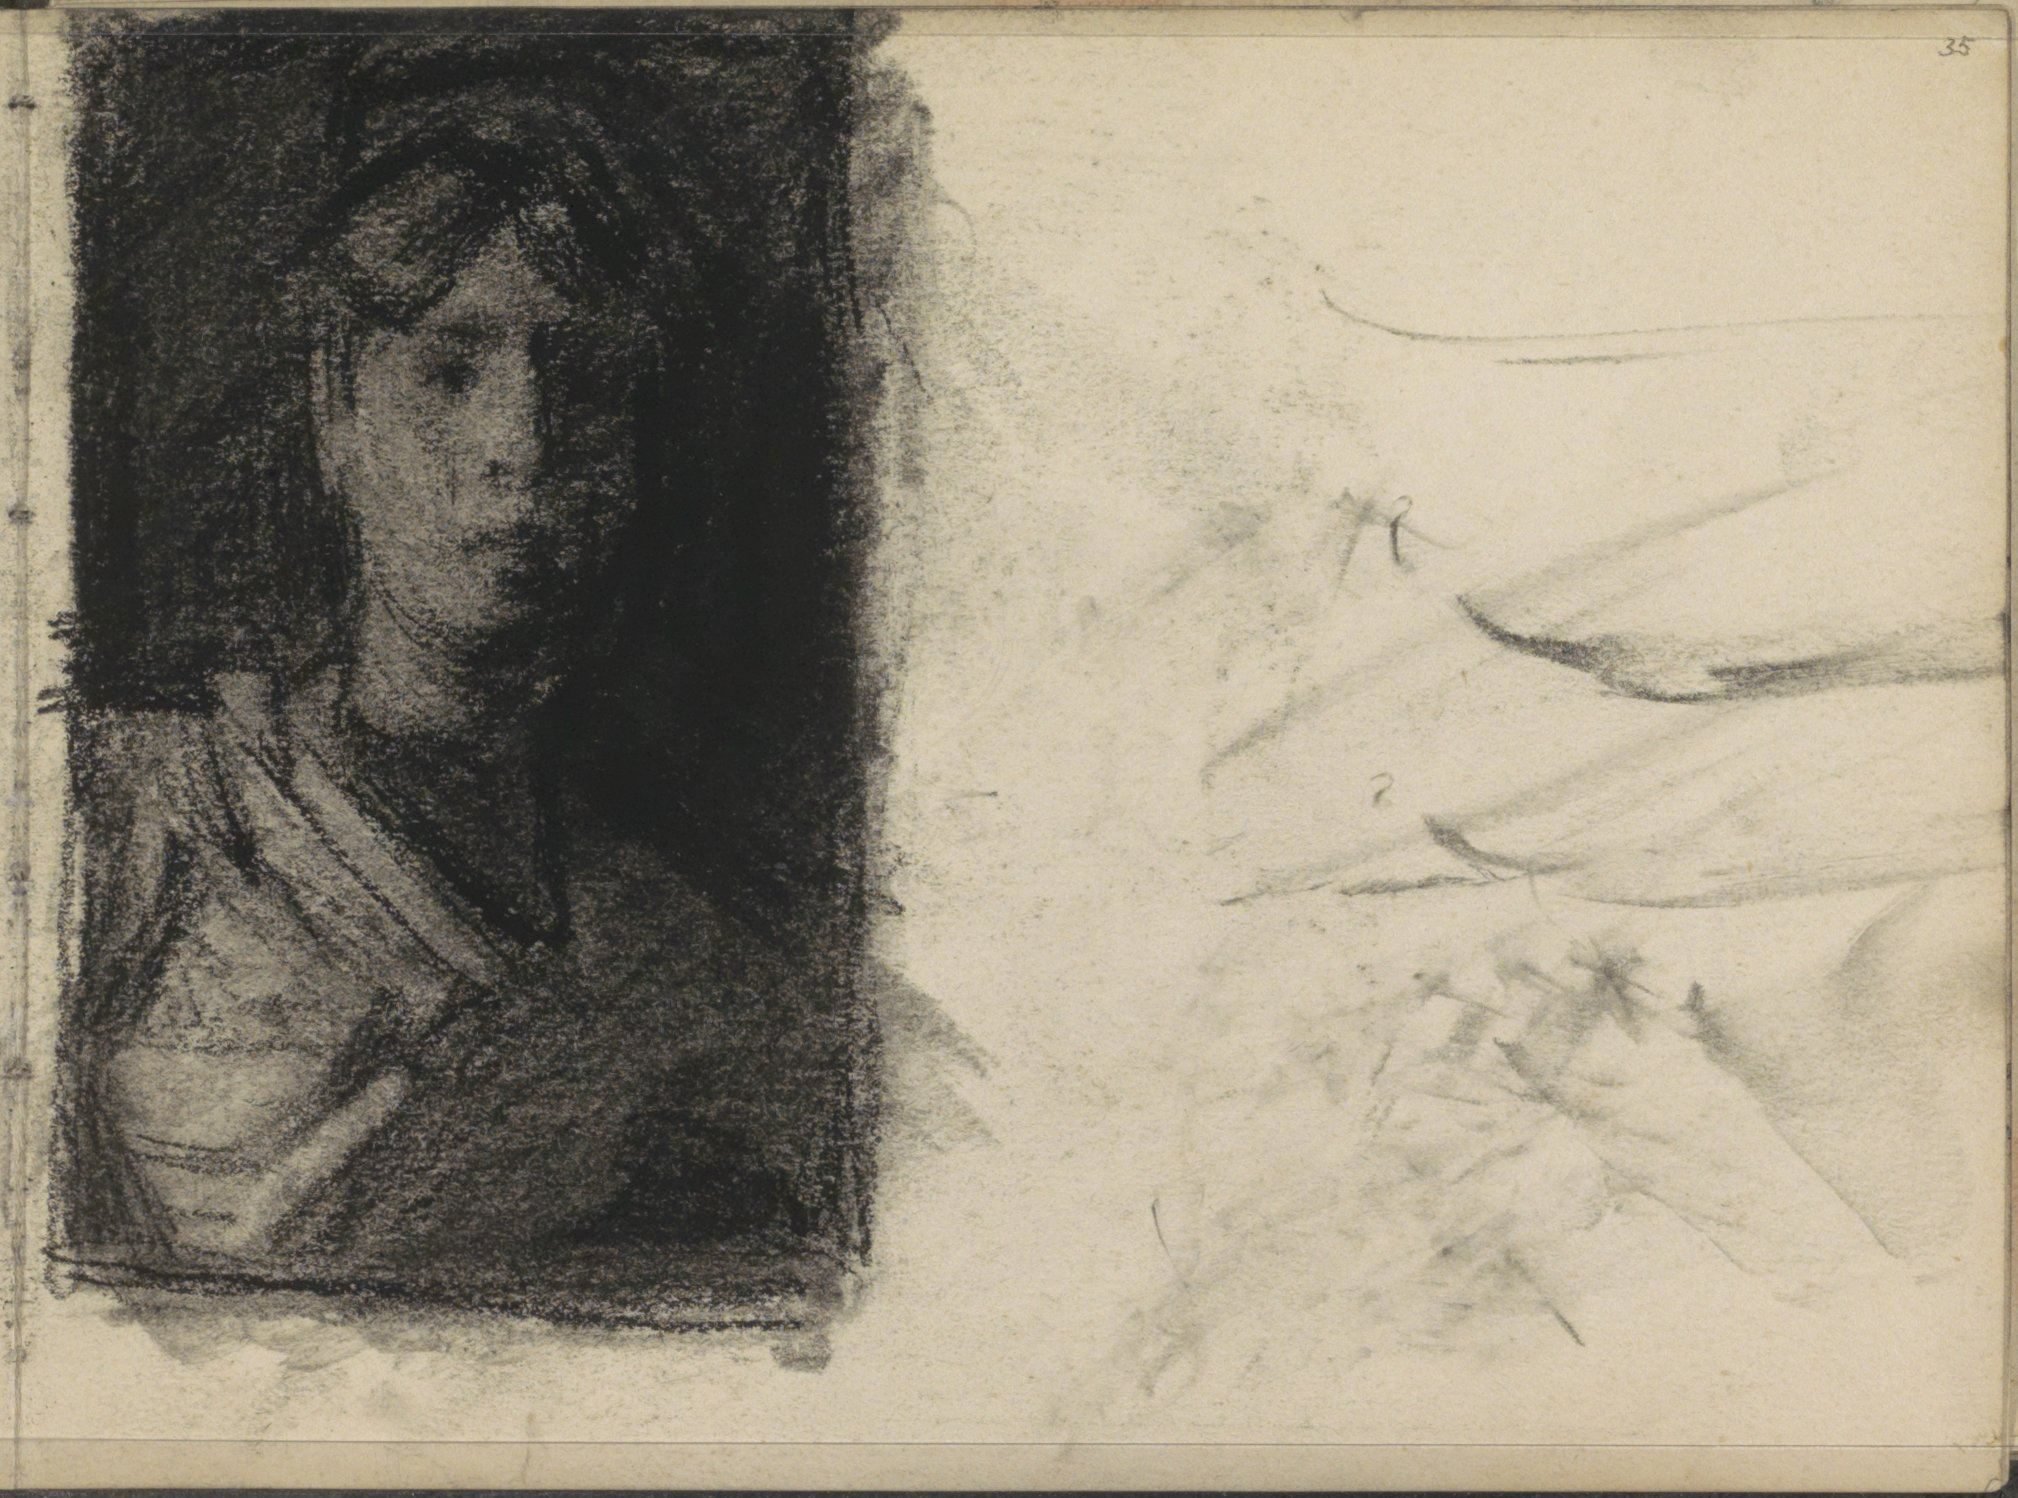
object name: sketchbook leaf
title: Vrouwenkop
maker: marius bauer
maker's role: draughtsman, print maker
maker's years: 1867-1932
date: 1879-1884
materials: chalk, paper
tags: adult woman, clothing for the upper part of the body: blouse (+ women's clothes)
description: De vrouw is van voren gezien en ten halven lijven getekend. Zij draagt een blouse en heeft het haar opgestoken. Pagina 35 uit een schetsboek met 28 bladen.